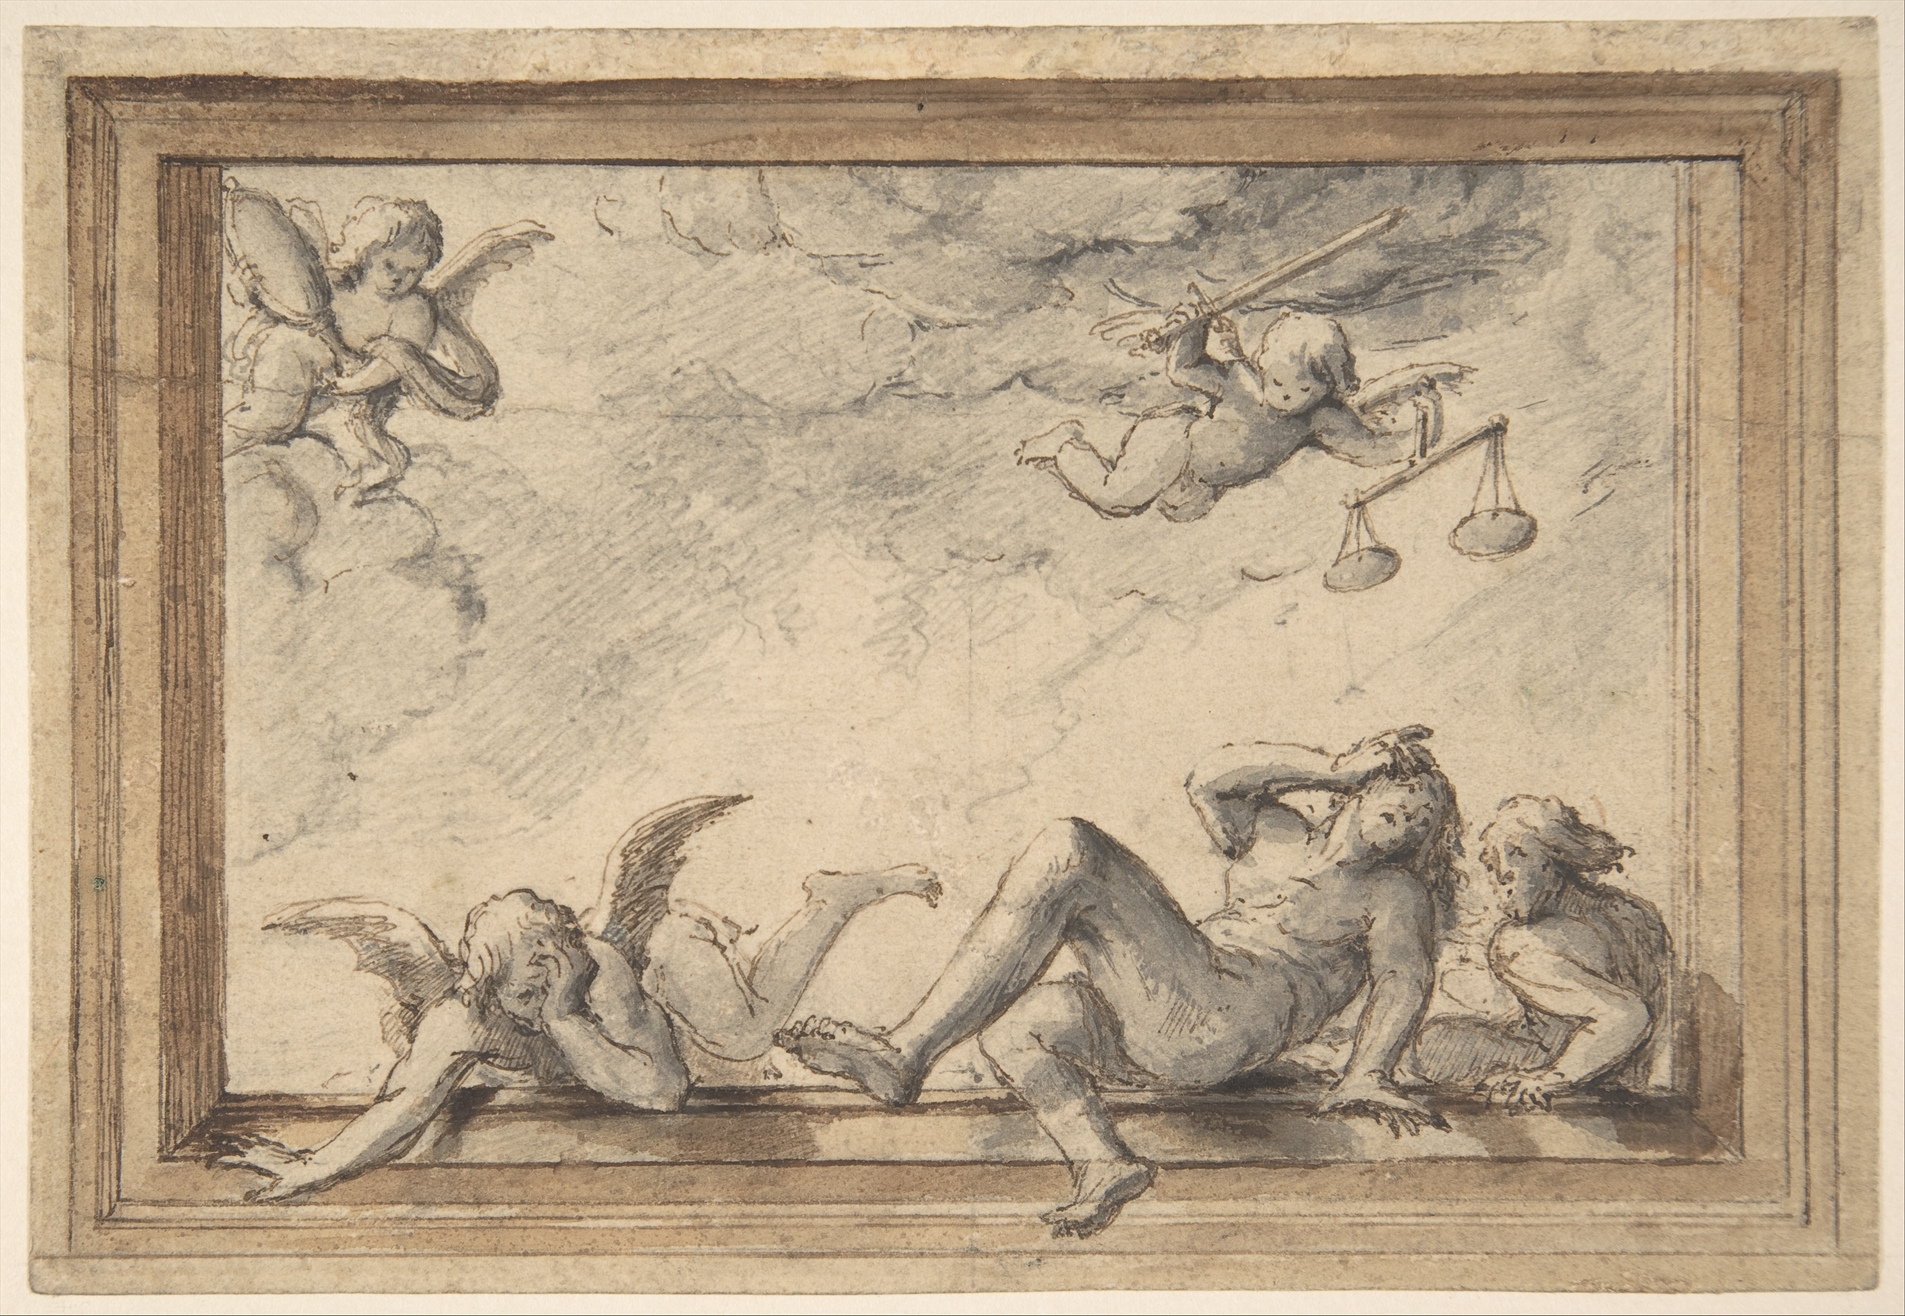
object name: drawing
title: Design for a ceiling with an allegory of Justice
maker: hendrik-frans verbruggen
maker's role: artist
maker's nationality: flemish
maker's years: 1654-1724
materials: graphite, ink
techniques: brush, pen, wash